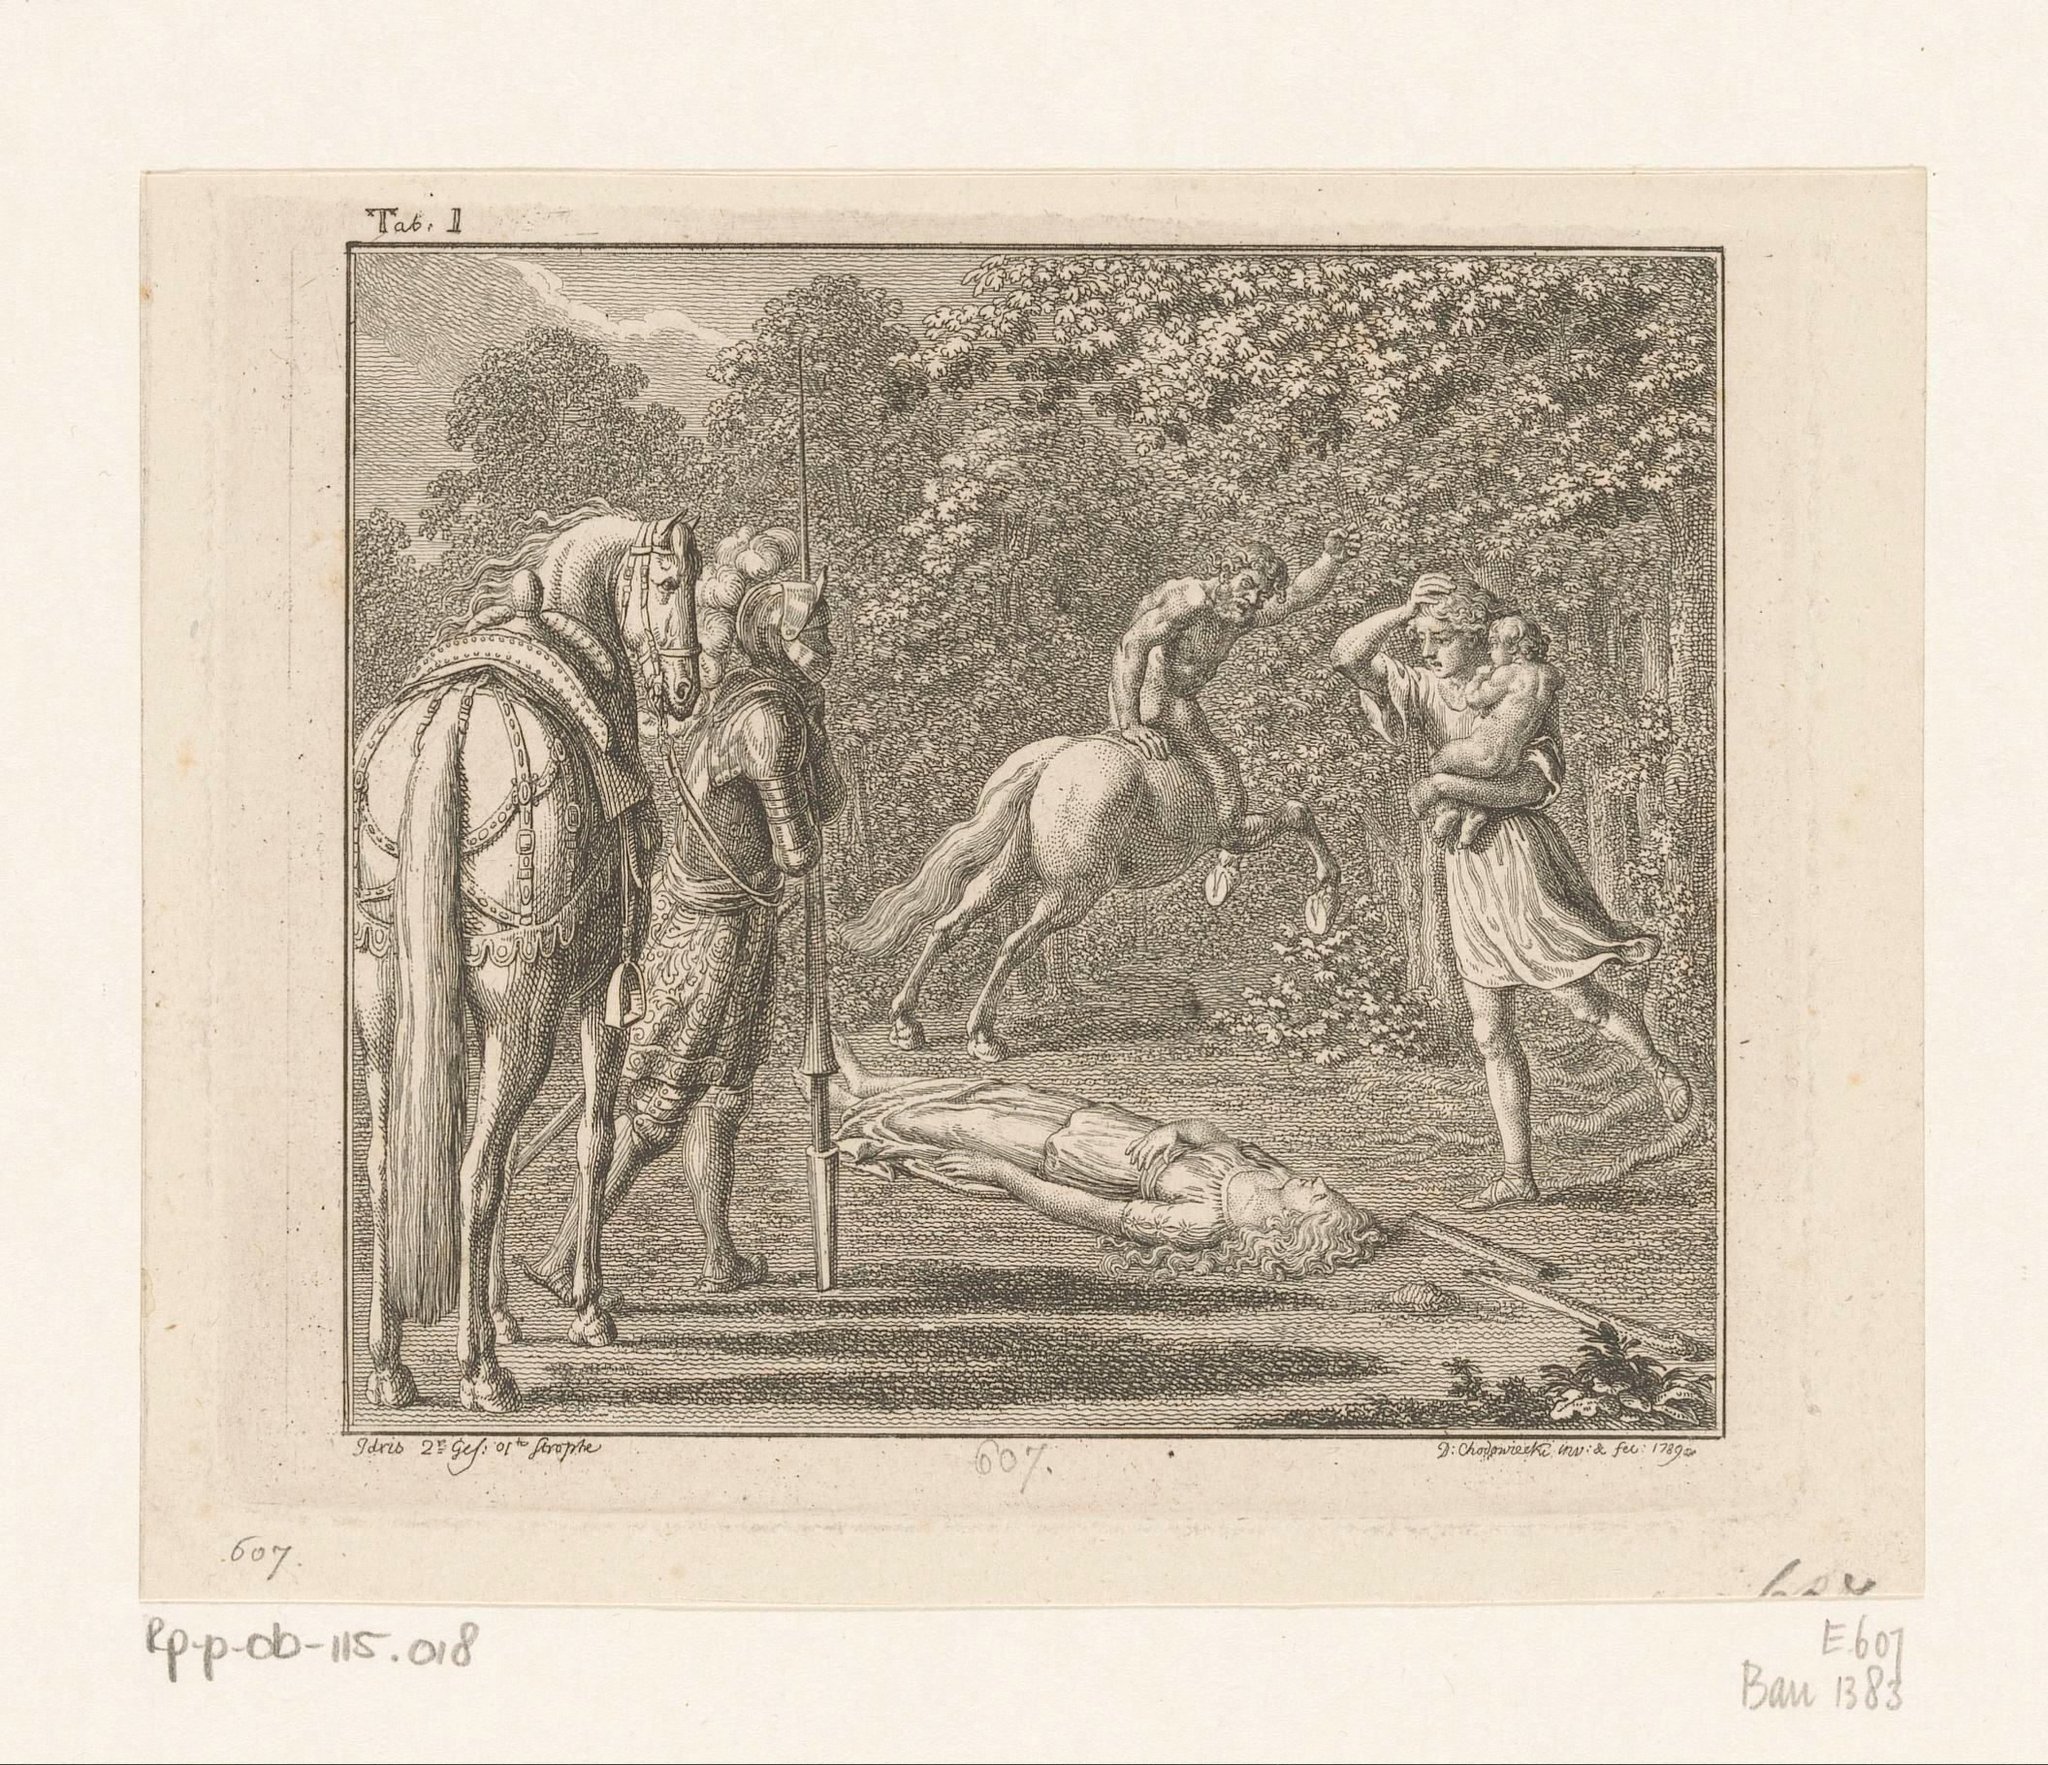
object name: print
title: Ridder Idris naast het lichaam van Lila terwijl de centaur vlucht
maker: daniel nikolaus chodowiecki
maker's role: draughtsman, print maker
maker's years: 1726-1801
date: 1789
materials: paper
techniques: etching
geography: berlin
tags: publisher, christoph martin wieland, centaurs, literature, knight, death of human being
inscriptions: collector's mark: Lugt 2228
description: Vervaardigd voor Christoph Martin Wielands 'Idris und Zenide'. Prent gebruikt voor: Königl. Grossbr. Genealogischer Kalender auf das Jahr 1790. Lauenburg: s.n., [1789].